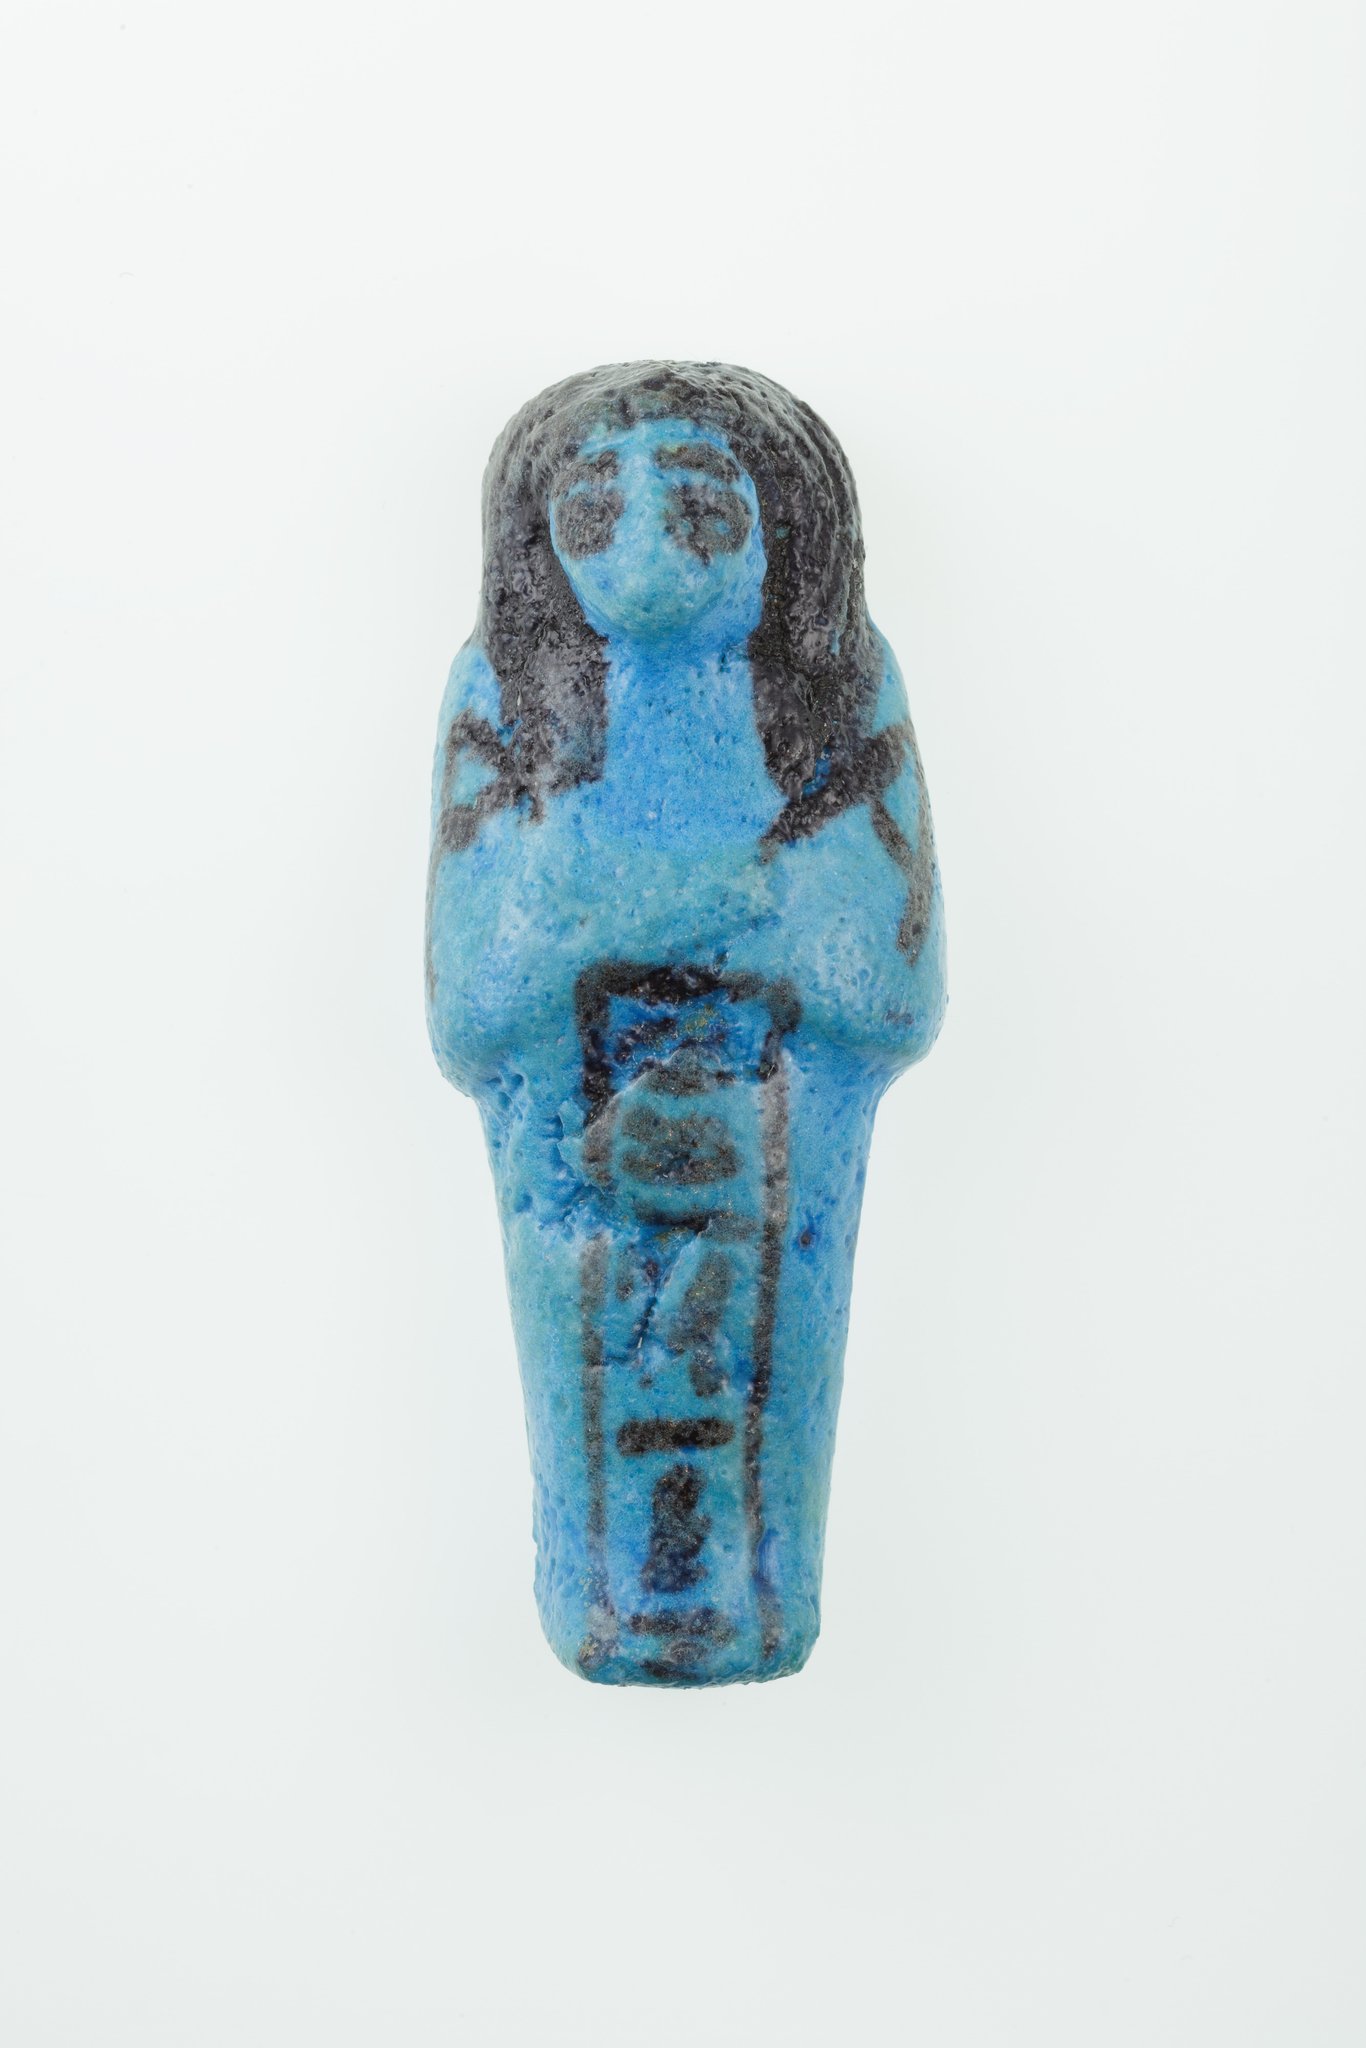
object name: shabti, worker, nauny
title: Worker Shabti of Nauny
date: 1050 BCE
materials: faience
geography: egypt